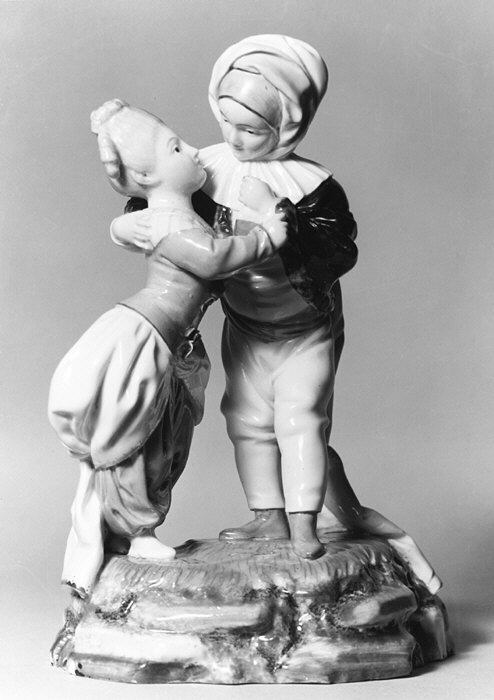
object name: group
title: Two children in Turkish costume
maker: höchst manufactory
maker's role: manufactory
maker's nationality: german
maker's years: 1746-1796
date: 1770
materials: hard paste porcelain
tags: boys,girls